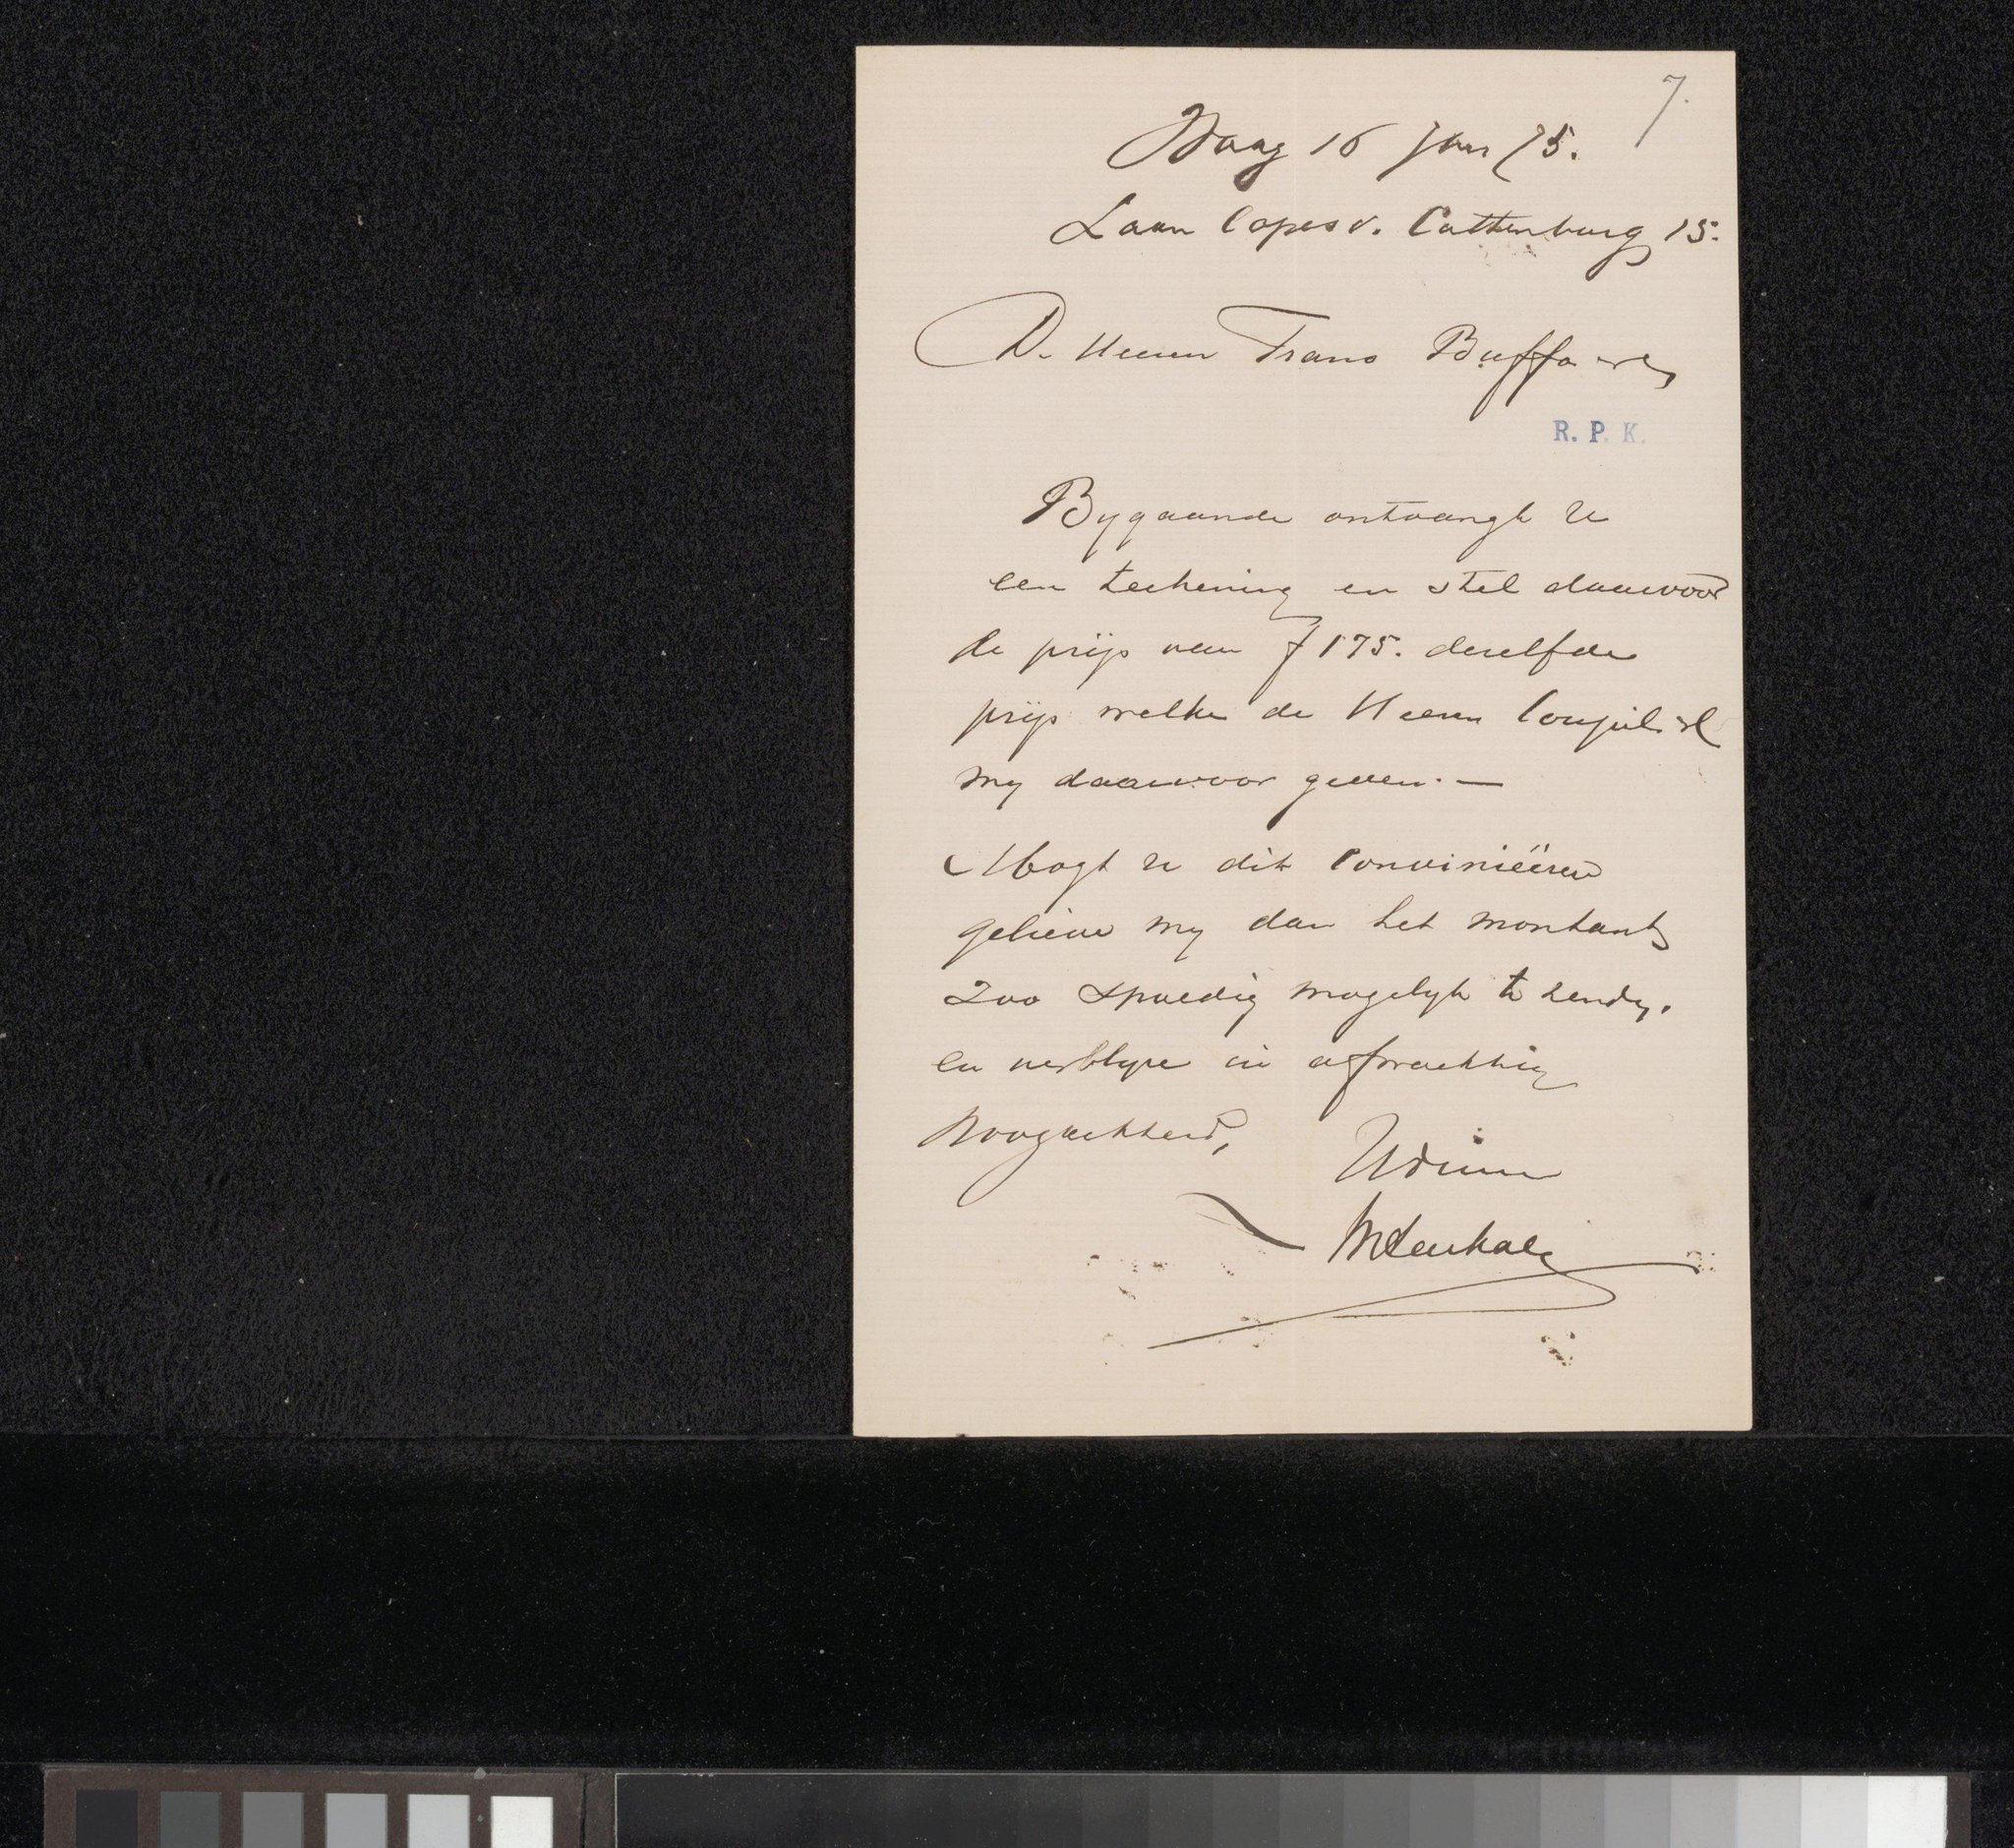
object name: letter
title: Brief aan Frans Buffa en Zonen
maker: mari ten kate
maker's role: draughtsman, painter, print maker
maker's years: 1831-1910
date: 1875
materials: ink, paper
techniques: pen, writing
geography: the hague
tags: publisher, printer, art trade, art shop, drawing, money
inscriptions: collector's mark: Lugt 2233